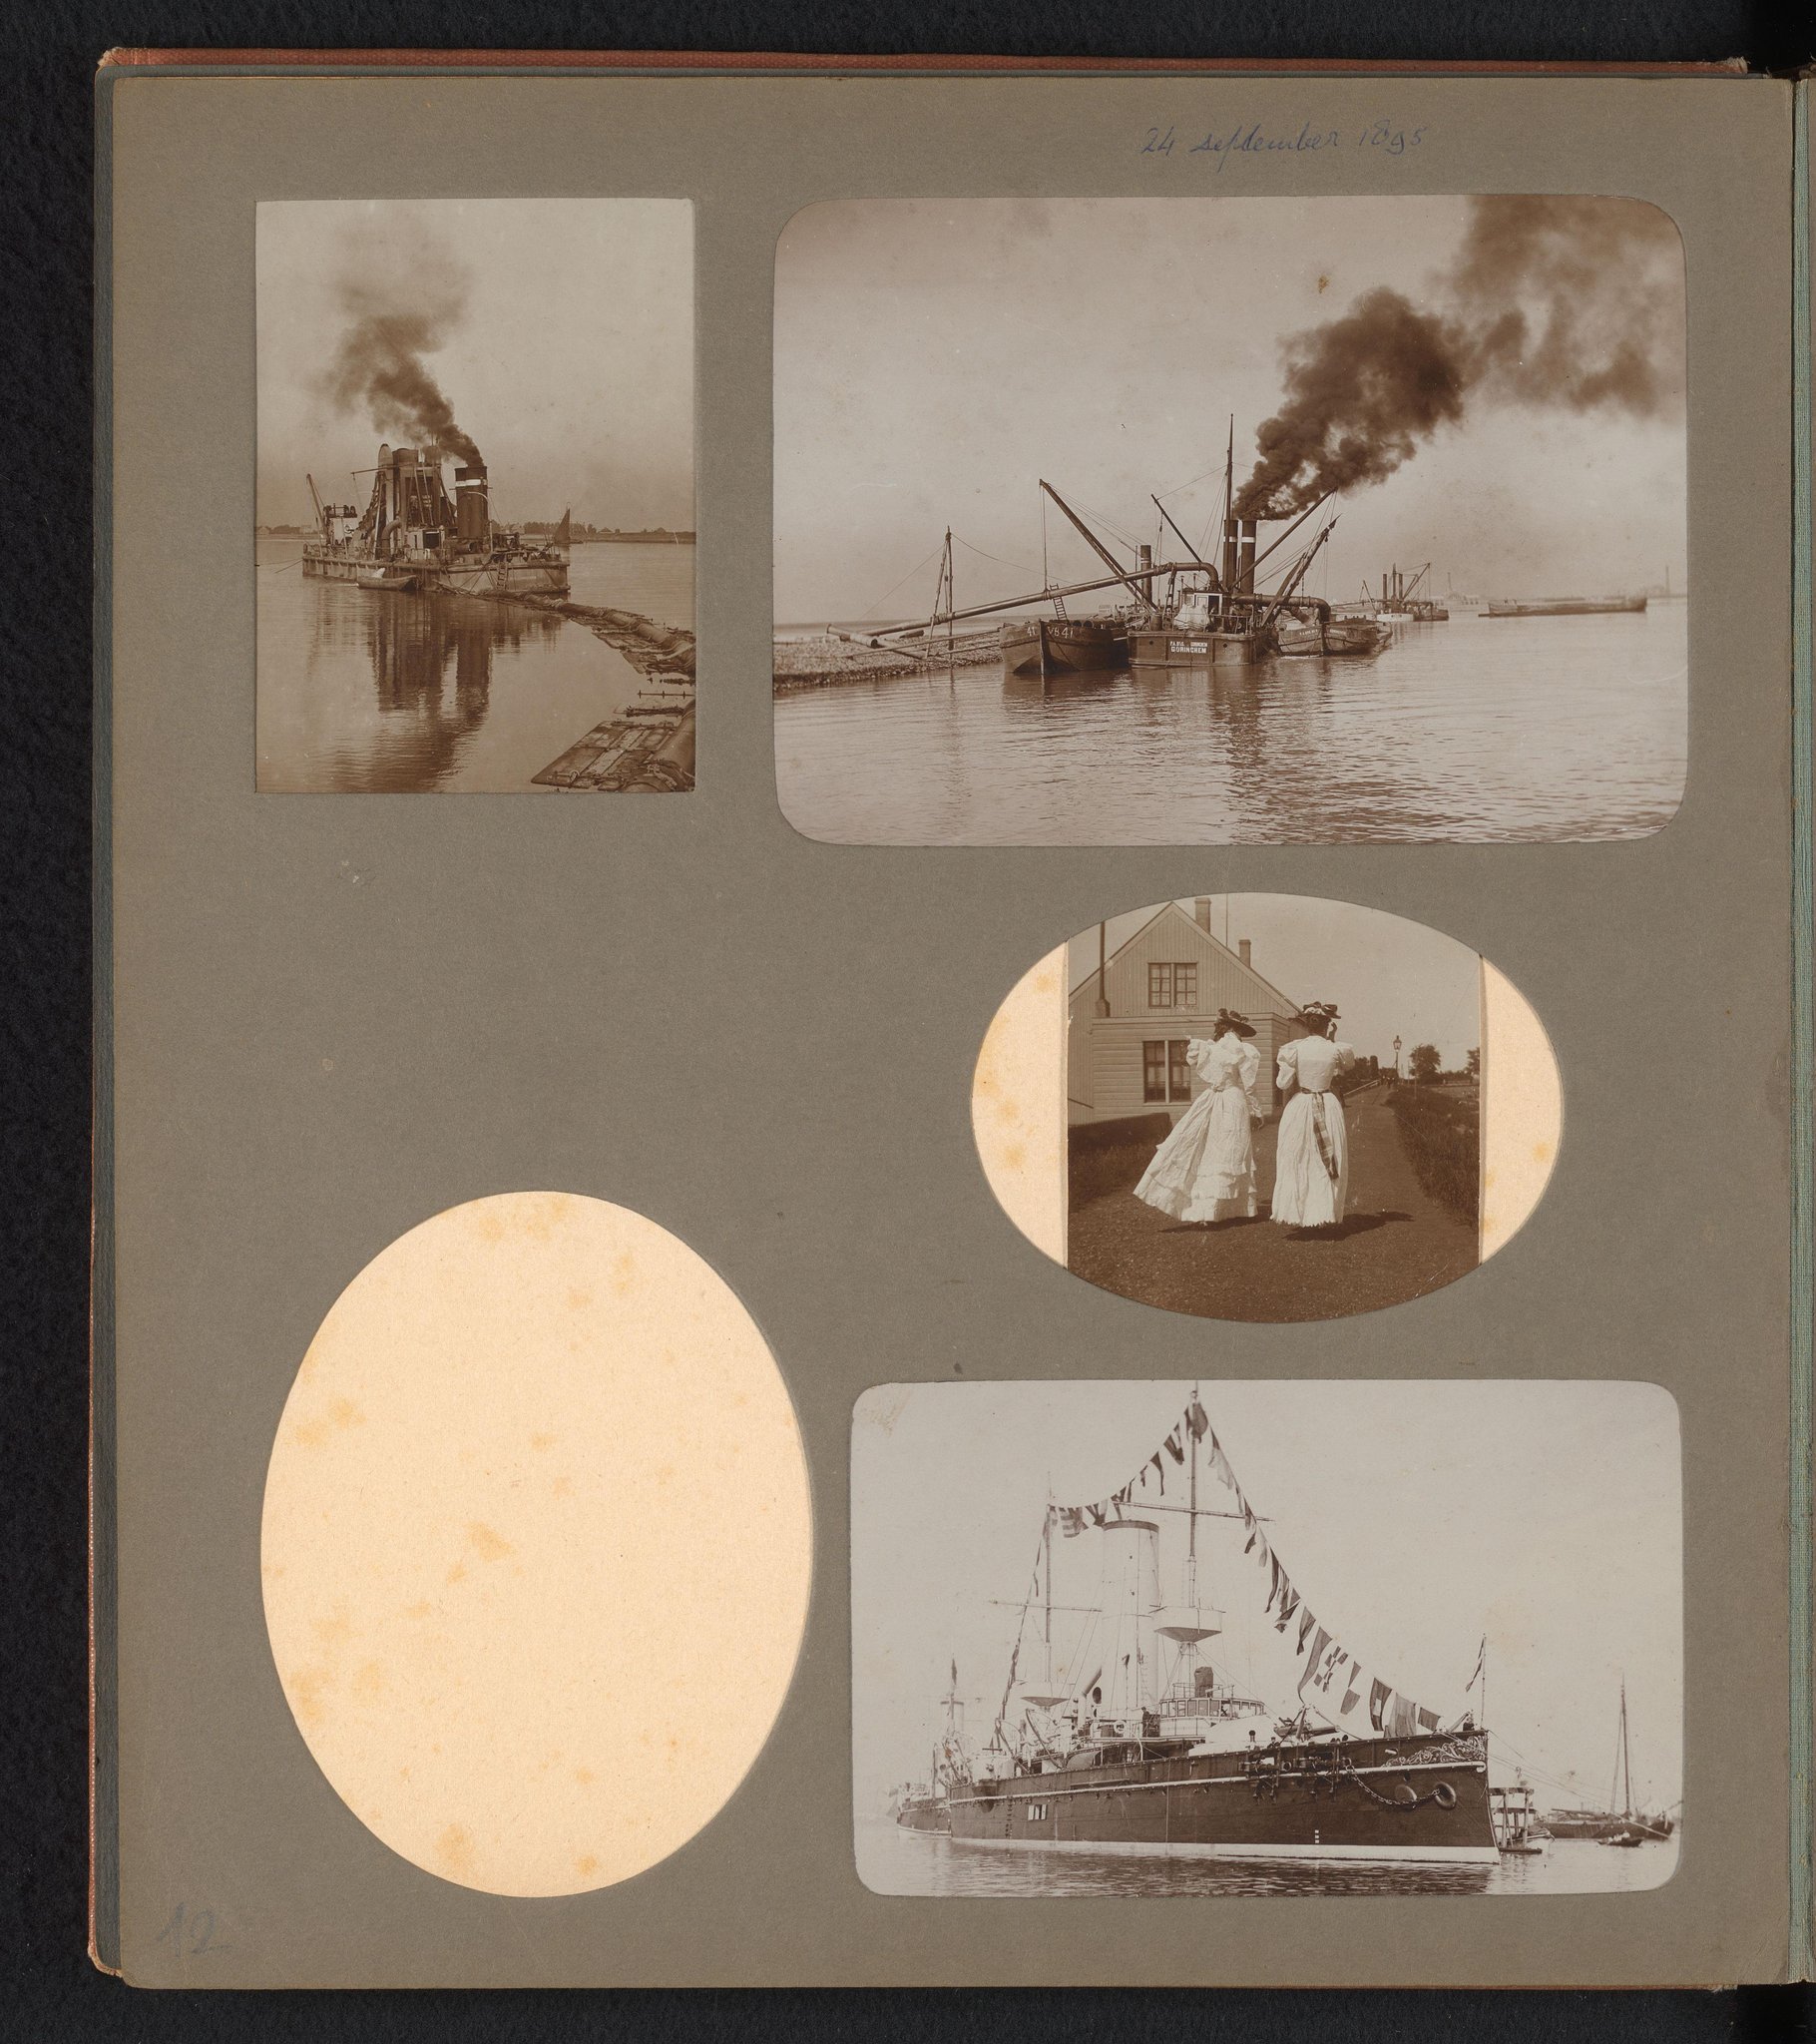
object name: photograph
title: Gezichten op schepen en twee lopende vrouwen gezien van achteren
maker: machiel gerrit george suyver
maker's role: fotograaf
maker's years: 1872-1933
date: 1895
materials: paper, cardboard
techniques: collodion silver print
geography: netherlands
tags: adult woman, ships (in general), amsterdam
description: Gezichten op twee schepen van Volker, klant van H. & J. Suyver's fabriek van stoomketels en werktuigen, twee lopende vrouwen gezien van achteren en een schip. Deze foto's maken deel uit van een album.